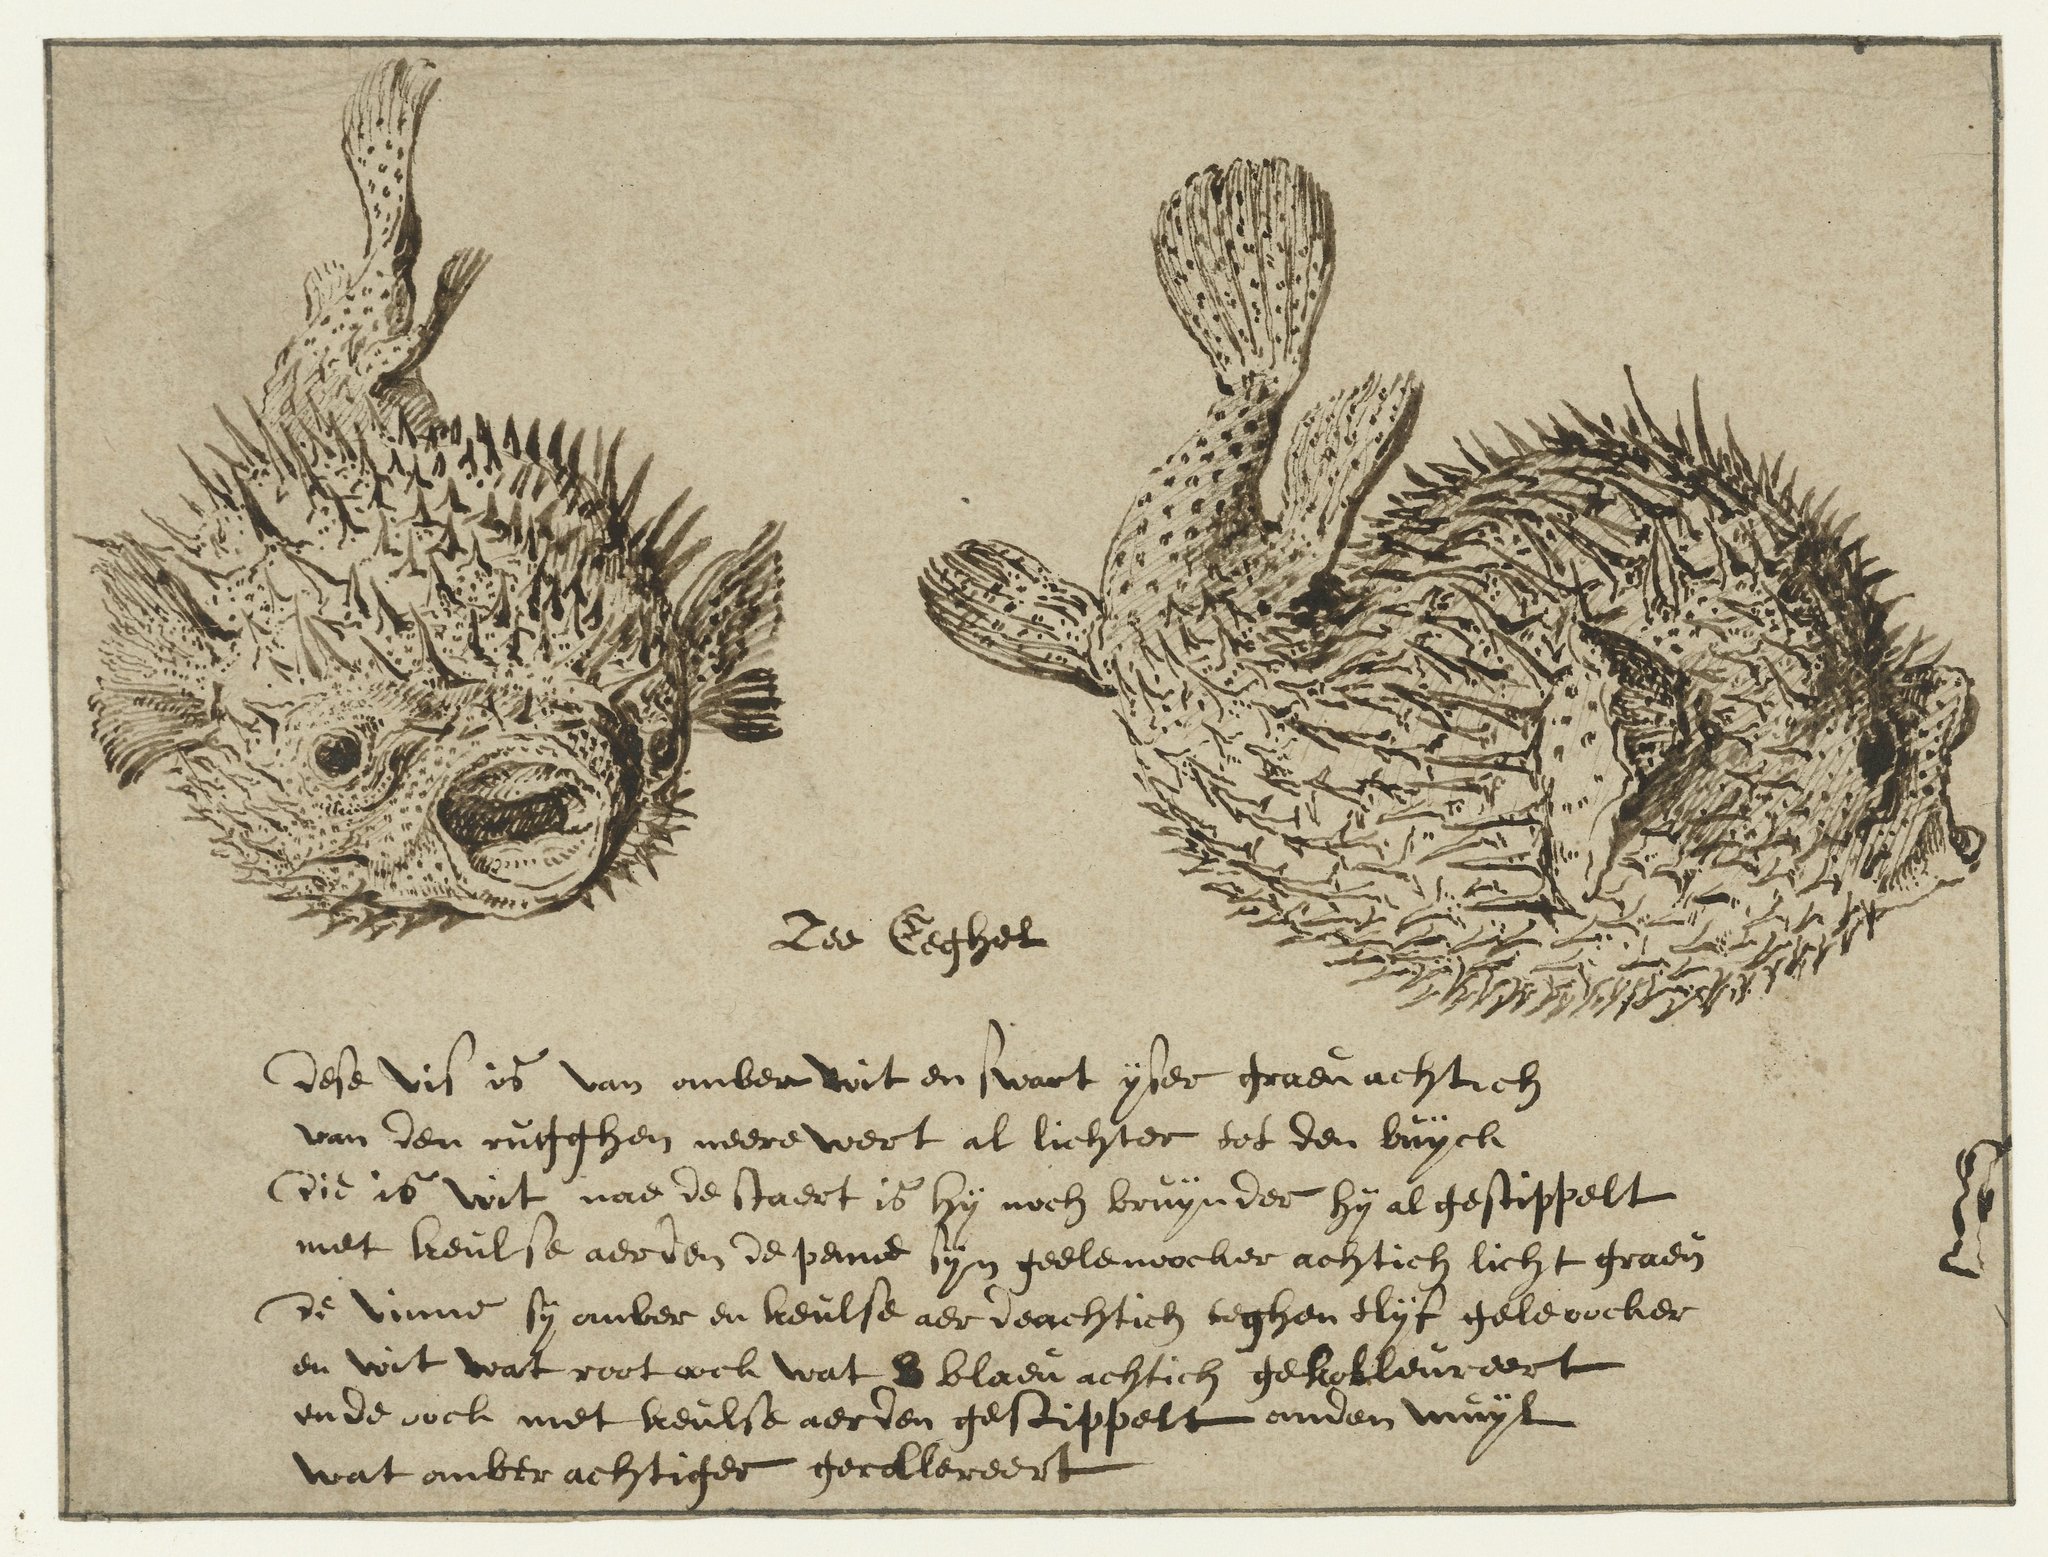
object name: drawing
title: Studies of a Blowfish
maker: jacques de gheyn (ii)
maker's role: painter, print maker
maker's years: 1565-1629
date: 1575-1625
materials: ink, paper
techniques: pen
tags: echinoderms: sea-urchin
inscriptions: inscription: ‘Zee Eeghel/ dese vis is van omber wit en swart ijser graeu achtich/ van den rugghen neerewert al lichter tot den buijck/ die is wit nae de staert is hij noch bruijnder hij al gestippelt/ met keulse aerden de penne sijn geelenoocker achtich licht graeu/ de vinne sij[n] omber en keulse aerdeachtich teghen tlijf gele oocker/ en wit wat root oock wat blaeu achtich gekolleureert/ ende oock met keulse aerden gestippelt omden muijl/ wat omber achtiger gecollereert’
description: In the late 16th century, artists became increasingly interested in natural history. Jacob de Gheyn counted several botanists and biologists among his friends. His knowledge and observational skills enabled him to draw plants and animals meticulously. He drew this tropical blowfish, a kind of puffer fish, from two sides, adding details about the colours below.